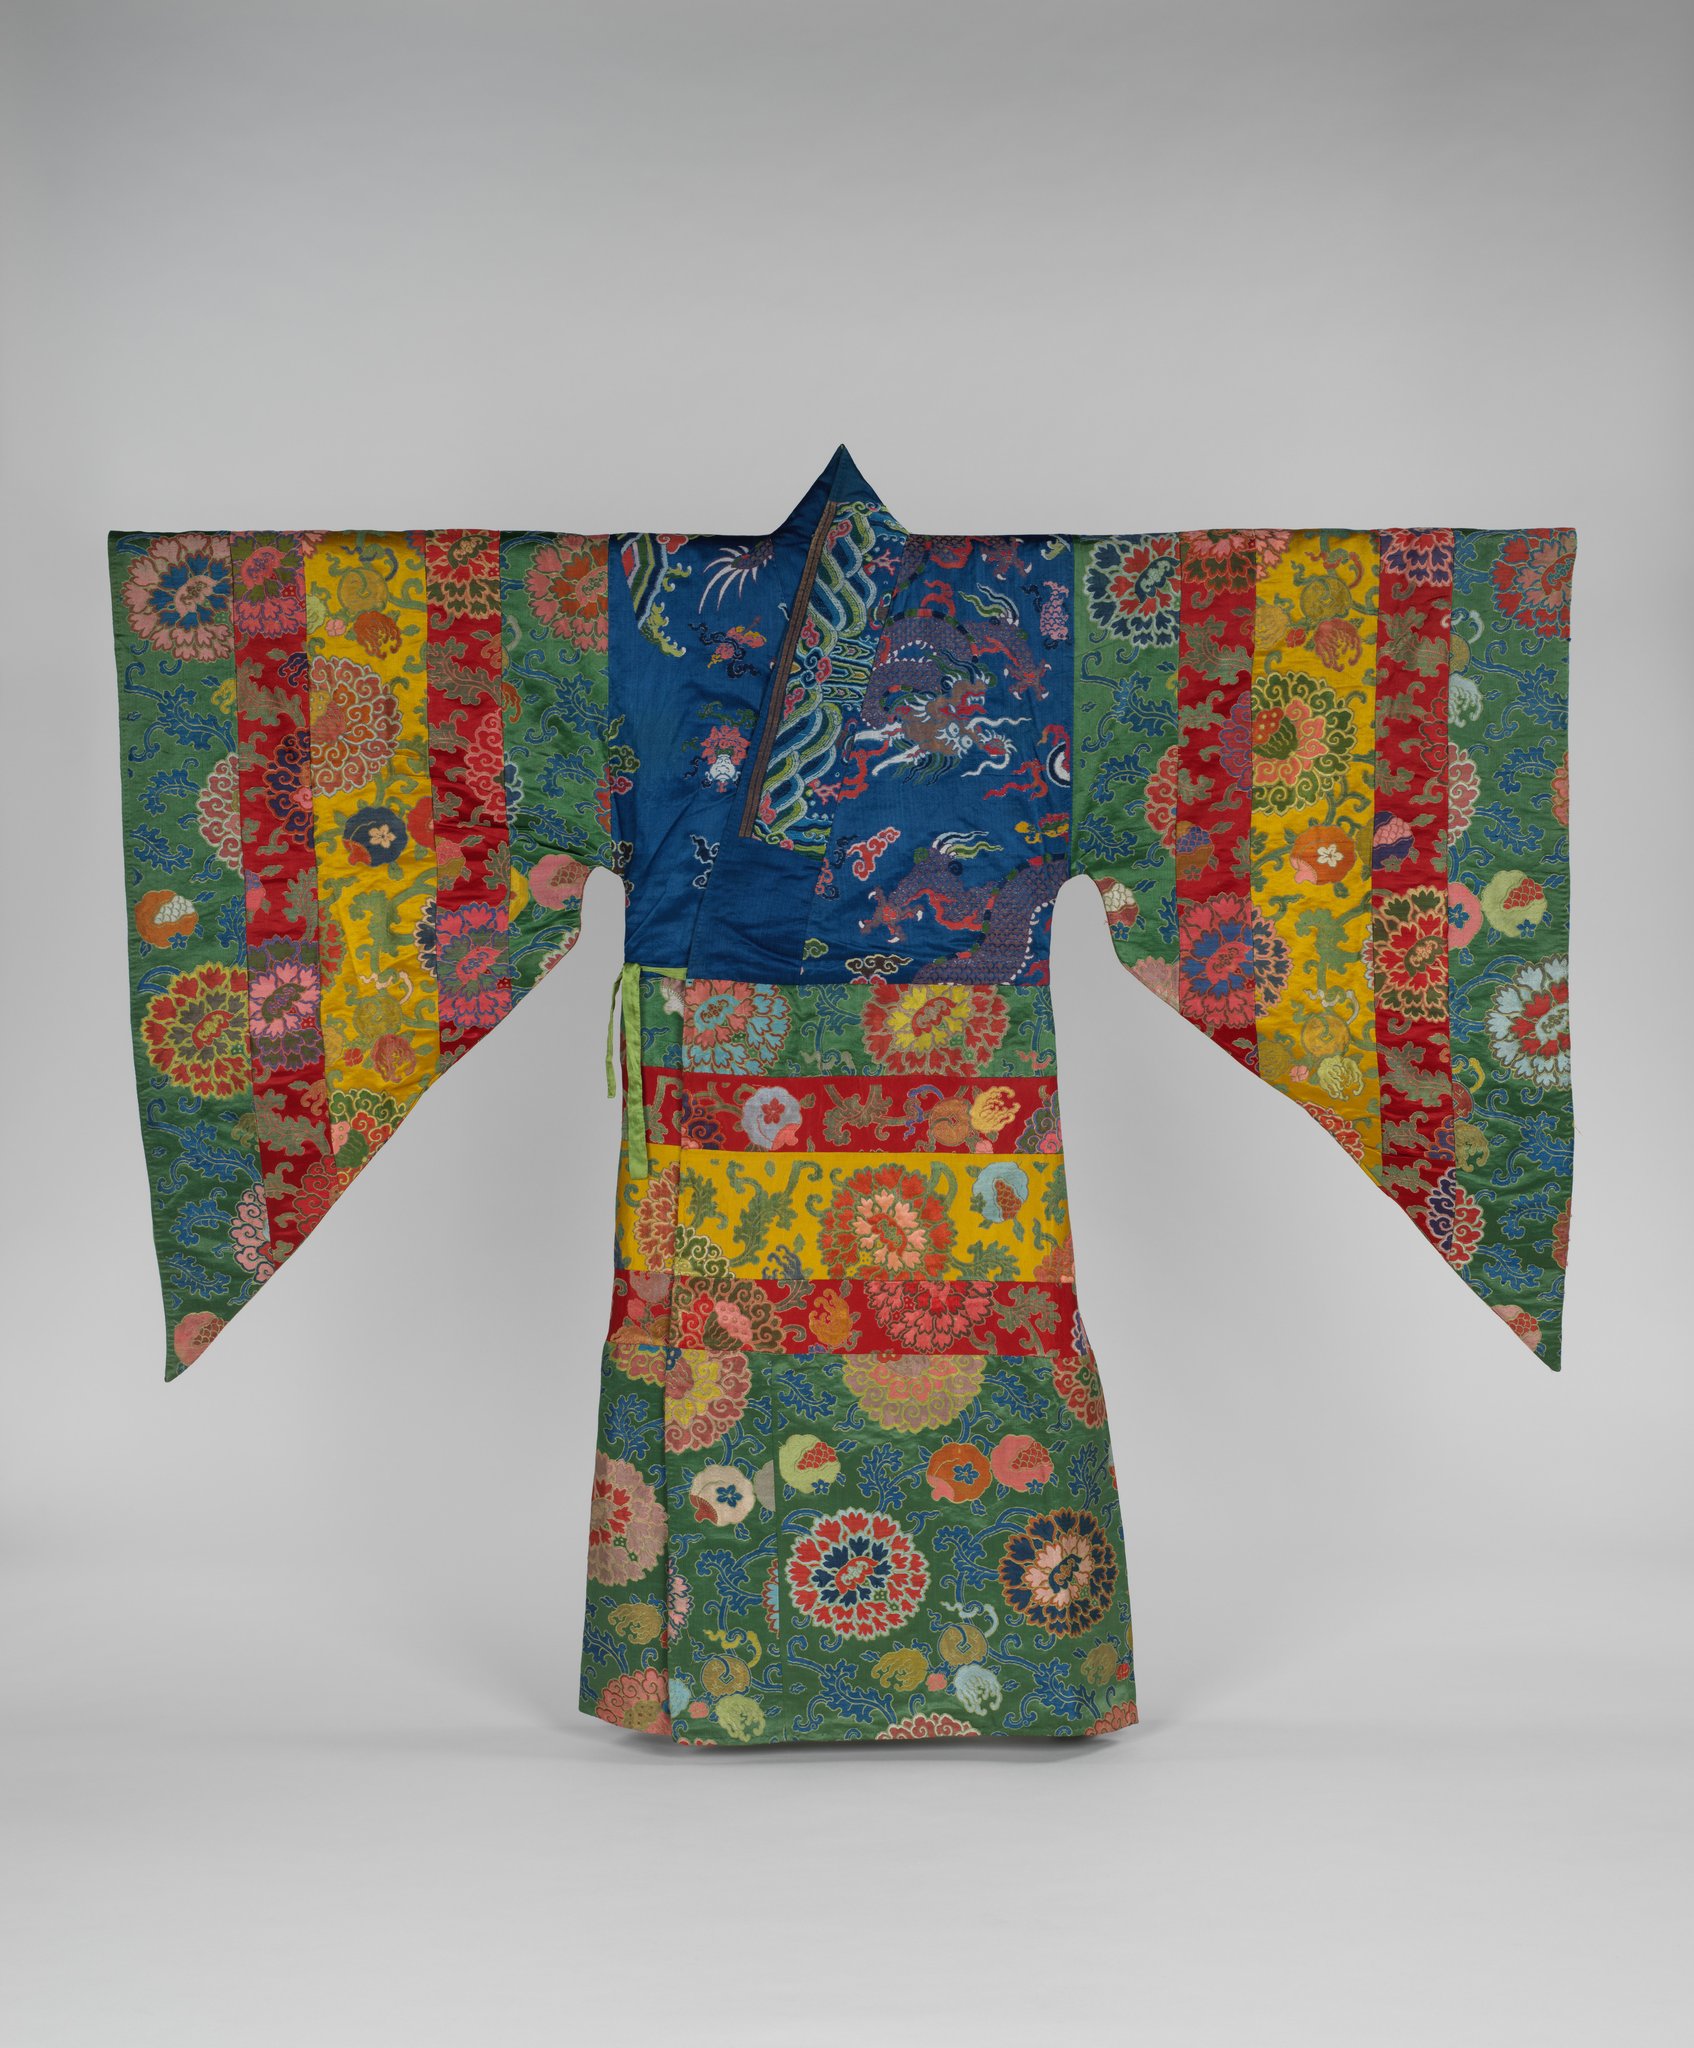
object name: robe, theatrical lama priest's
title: Monastic Dance Robe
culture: chinese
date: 1801-1833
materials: metal thread, silk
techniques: brocade, weave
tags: dragons